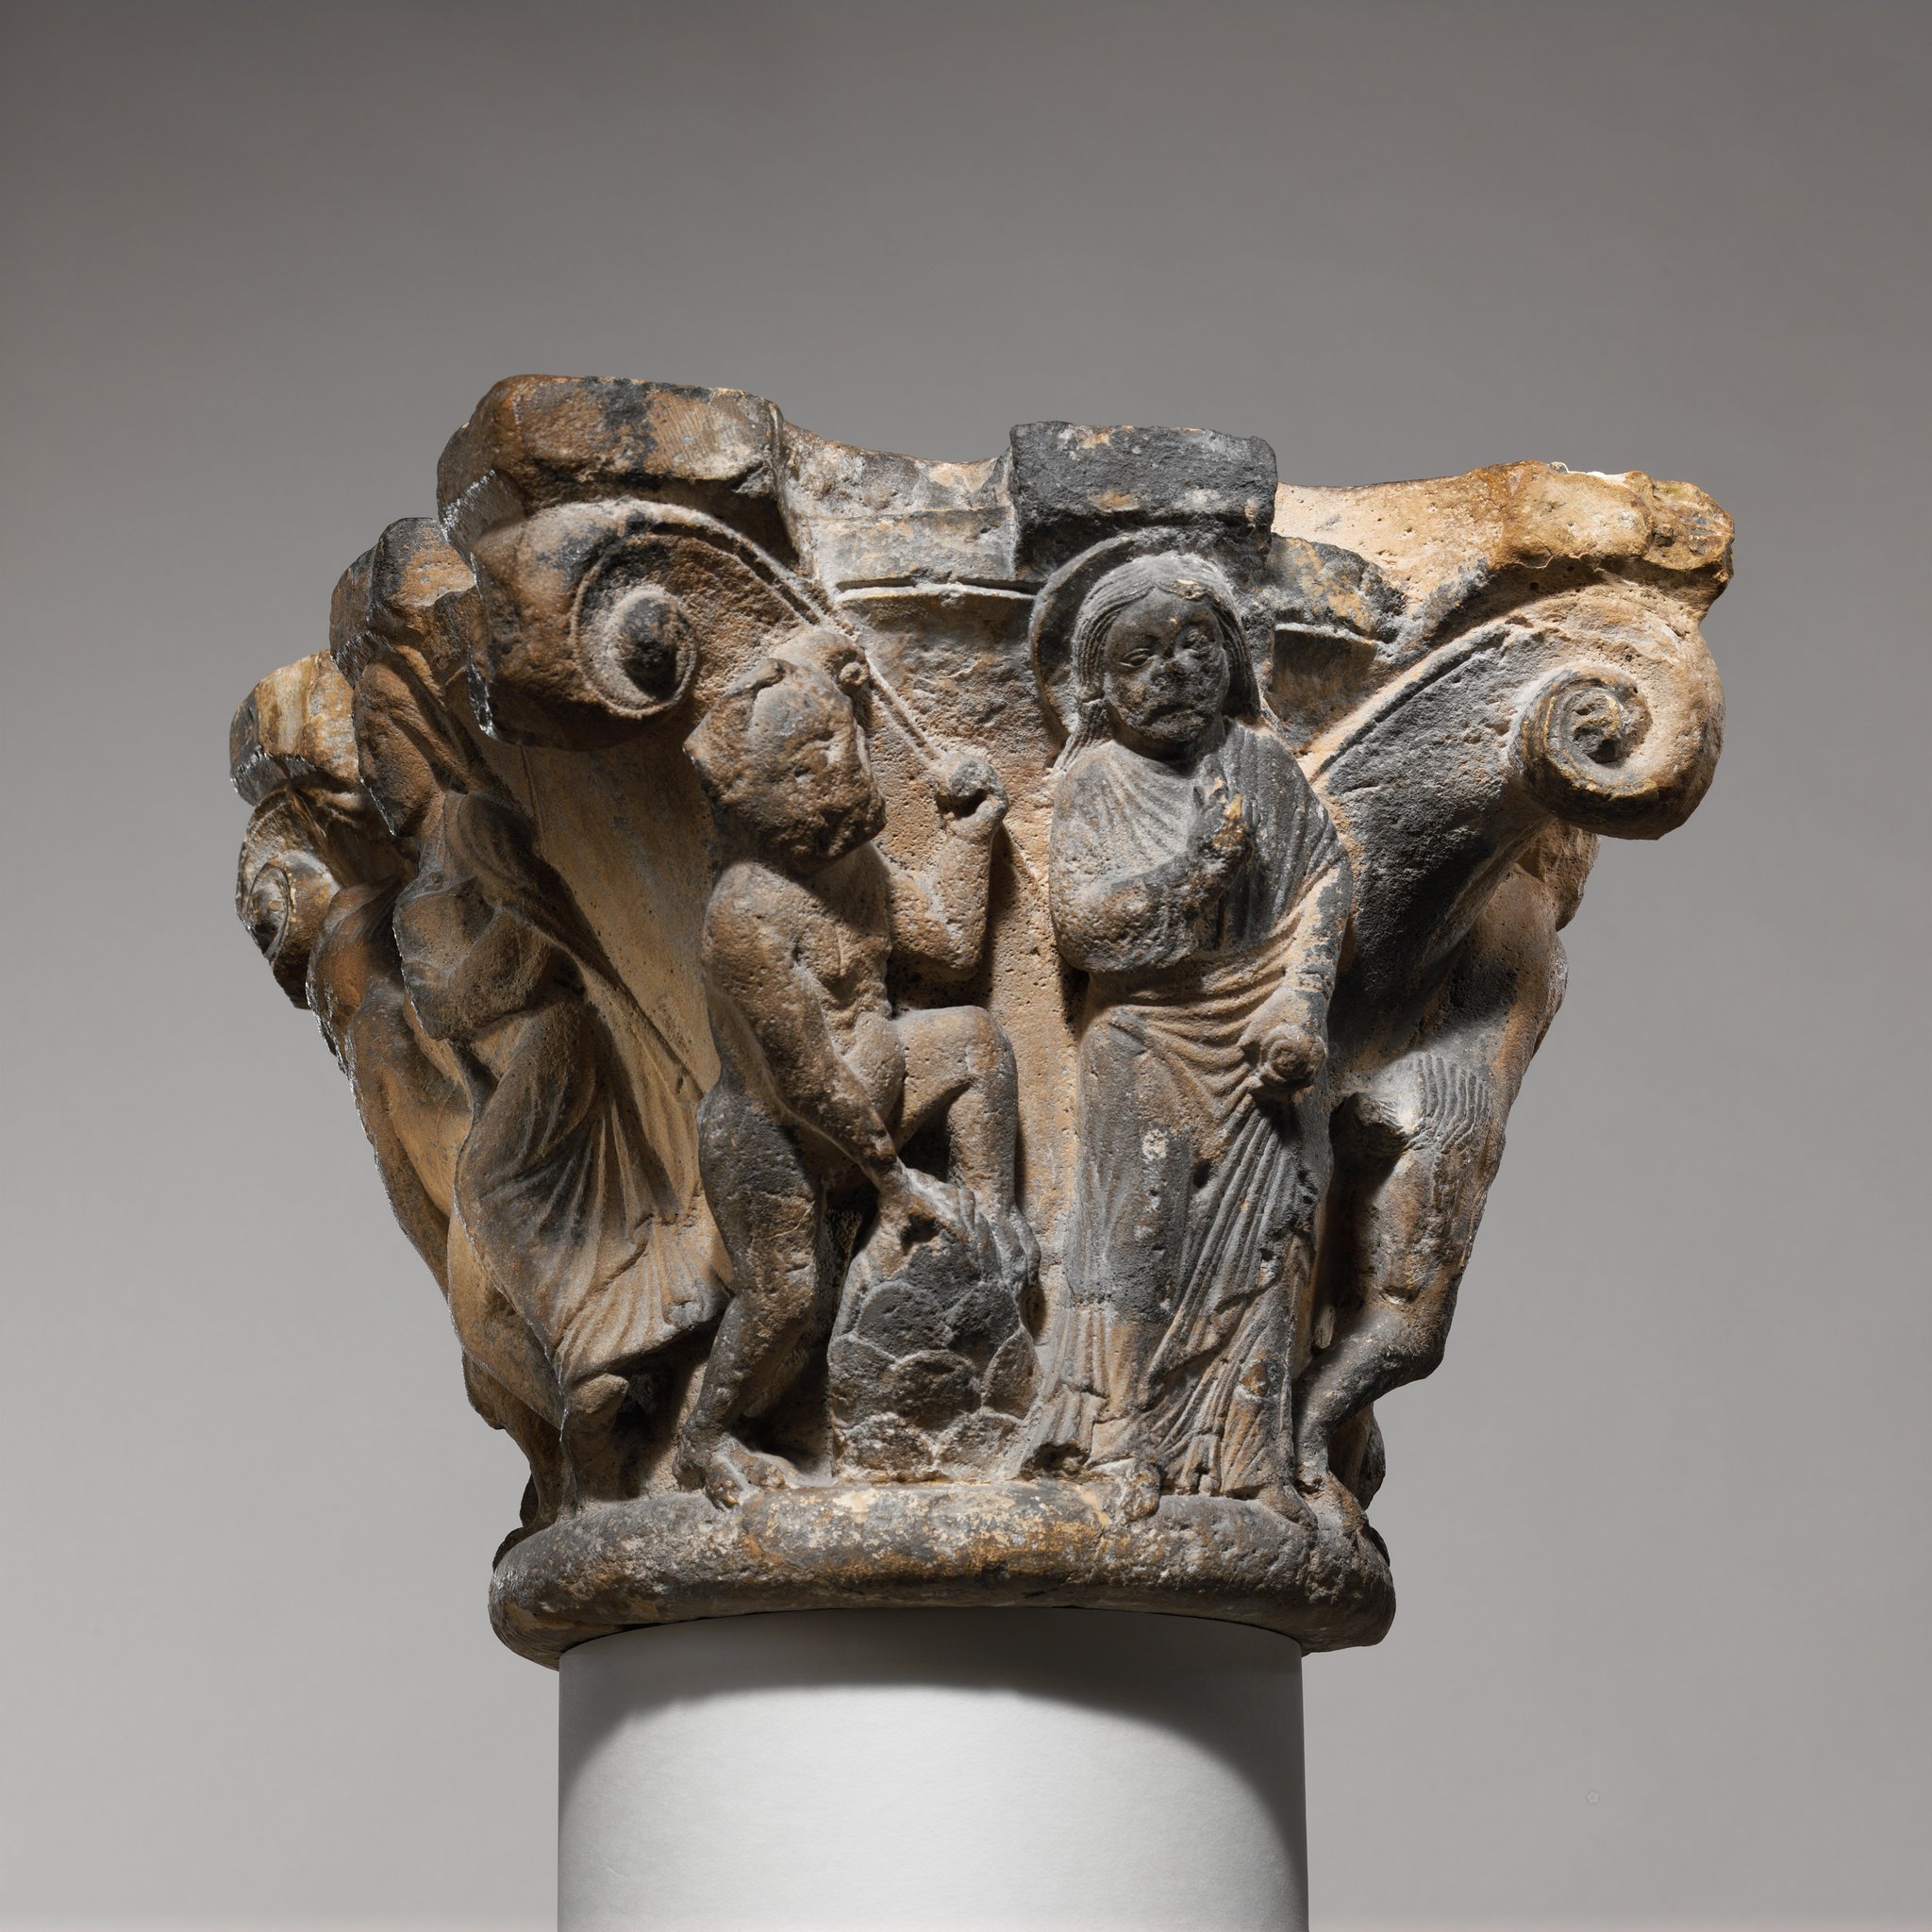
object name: capital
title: Capital with the Temptation of Jesus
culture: french, north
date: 1175-1200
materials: limestone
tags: devil,jesus